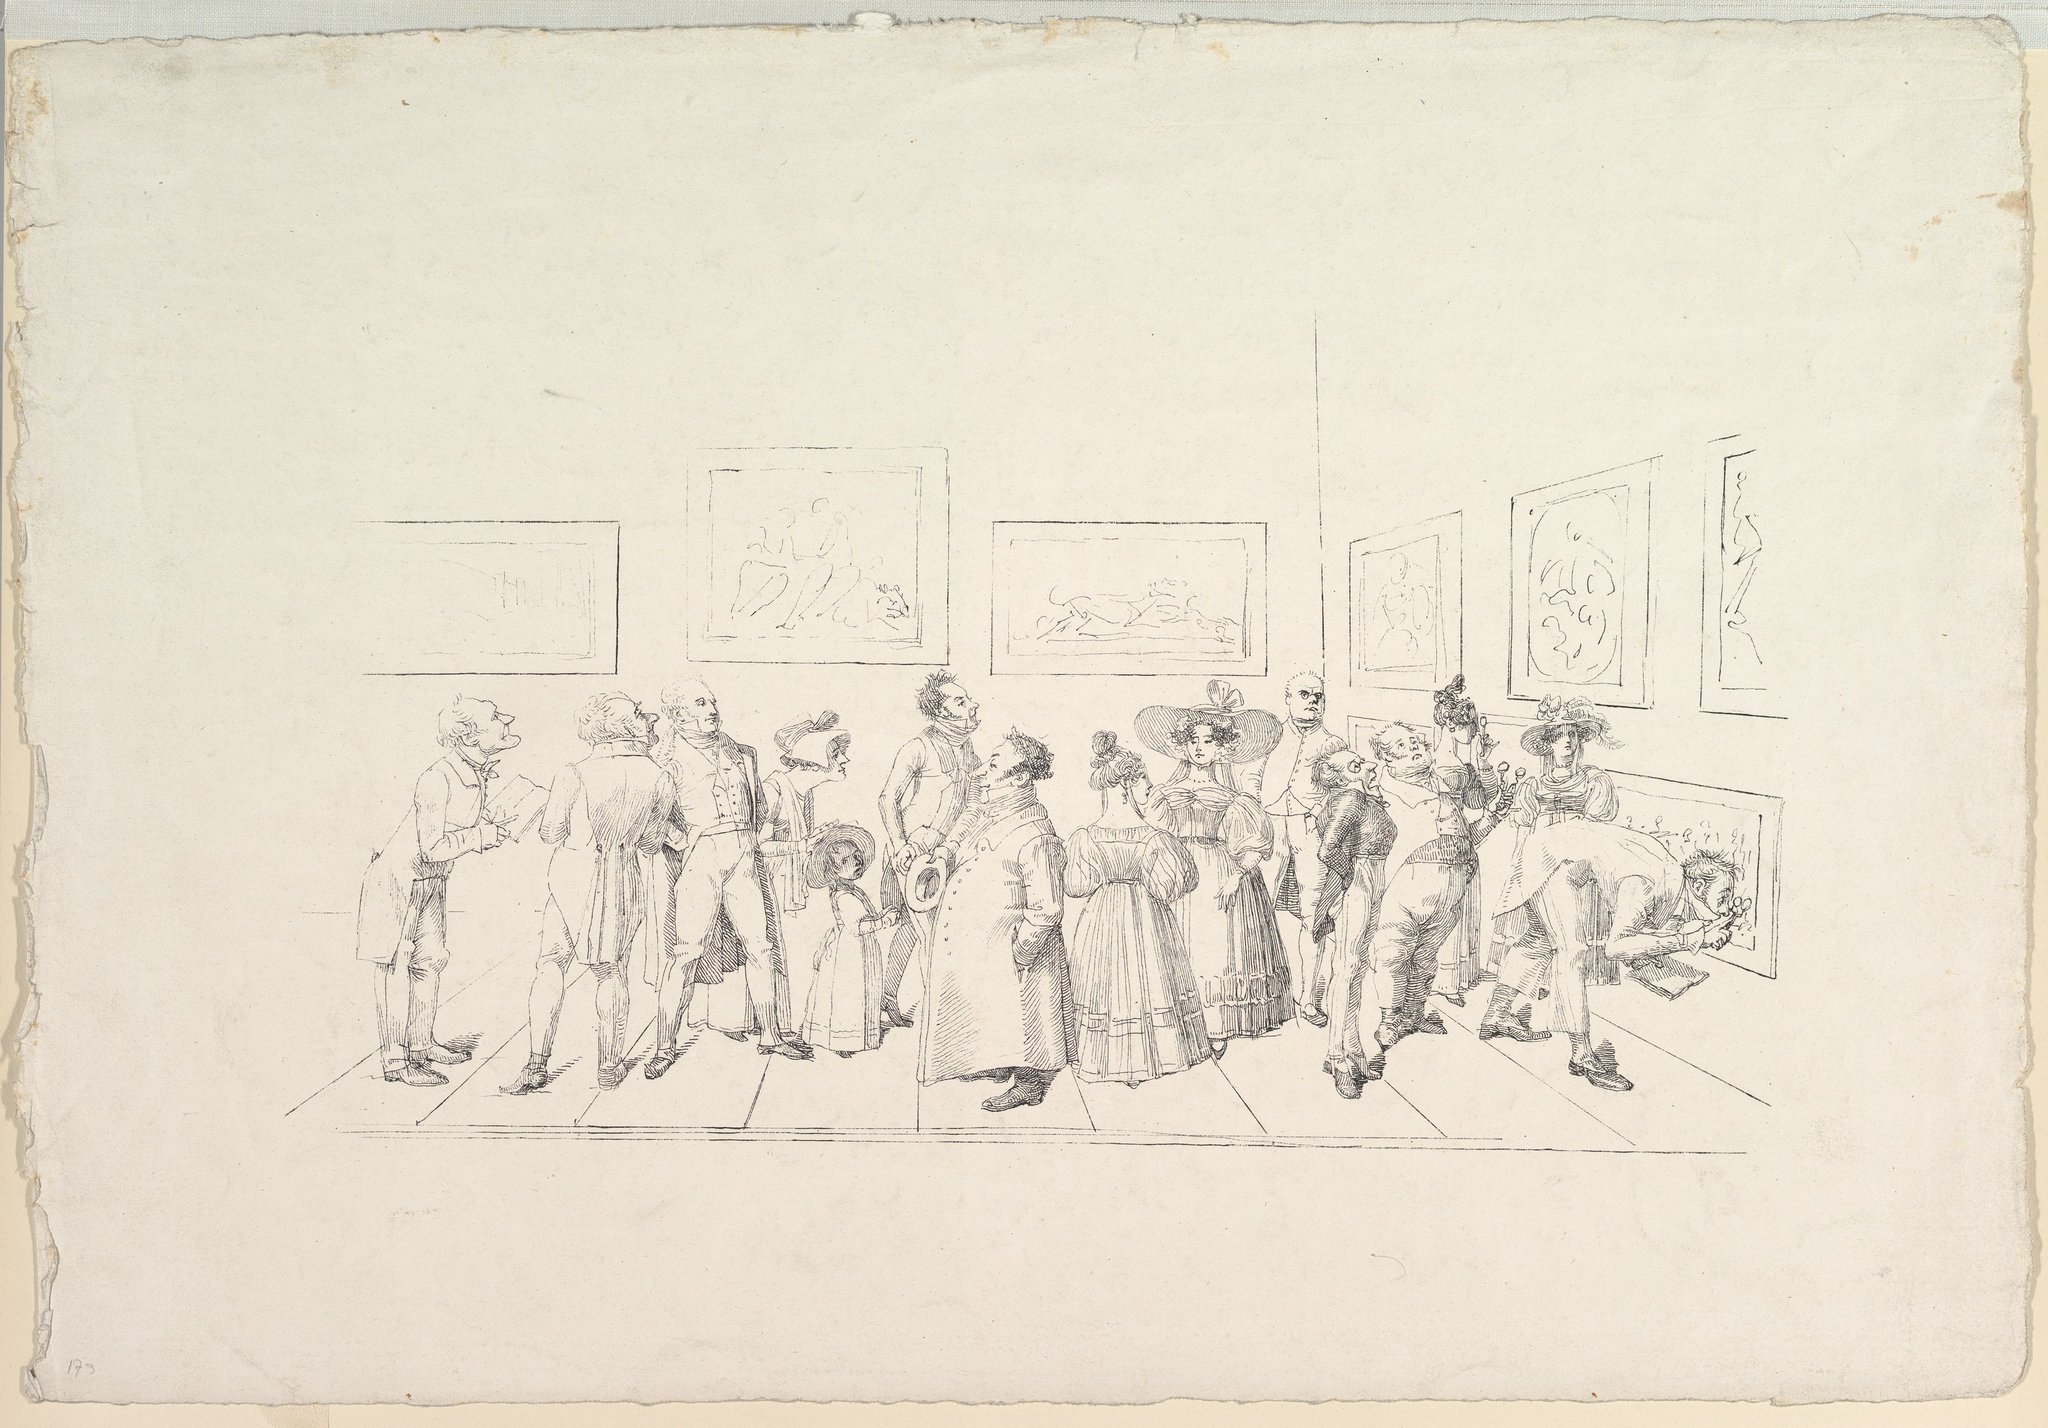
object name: print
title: The Public at an Exhibition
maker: johann gottfried schadow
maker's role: artist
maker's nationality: german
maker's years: 1764-1850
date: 1831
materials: zinc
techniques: lithograph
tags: men,women